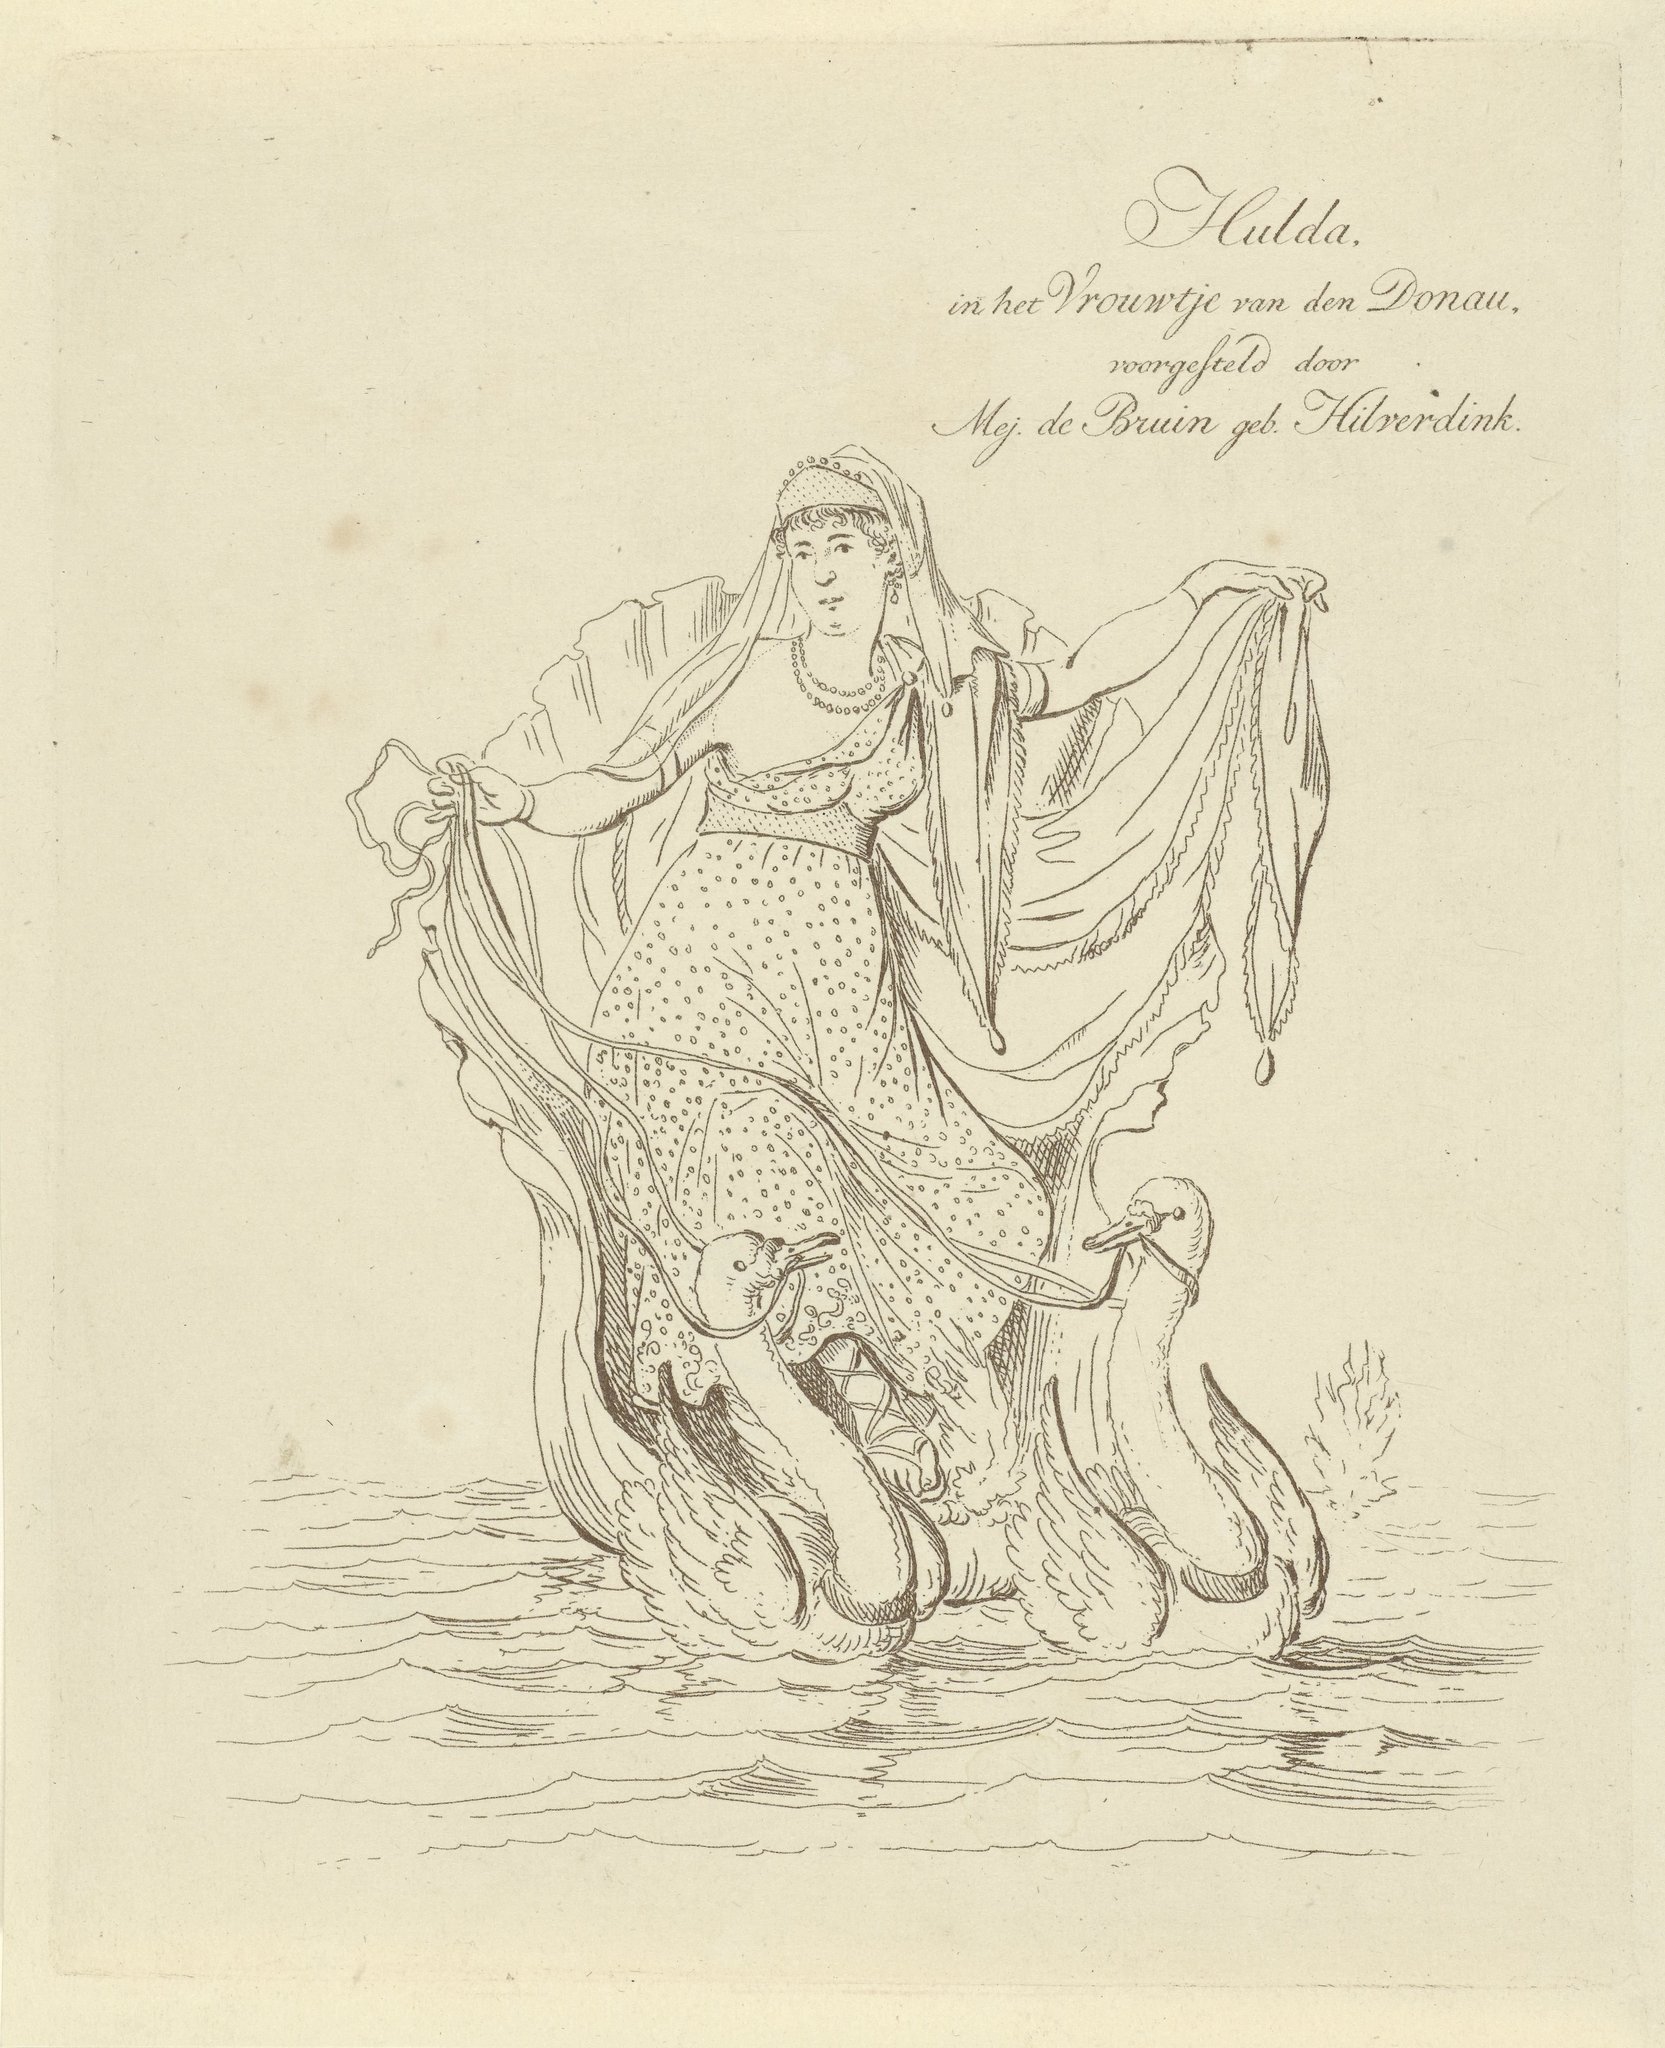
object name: print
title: Hulda, in het Vrouwtje van den Donau, (...)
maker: johannes jelgerhuis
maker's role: draughtsman, painter, print maker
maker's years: 1770-1836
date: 1805-1836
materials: paper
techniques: etching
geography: amsterdam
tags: actor (on the stage)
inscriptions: collector's mark: Lugt 2228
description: De actrice mevrouw De Bruin als Hulda, staand in een schelp op het water, getrokken door twee zwanen. Prent uit een serie van tien met Nederlandse acteurs en actrices in verschillende rollen.